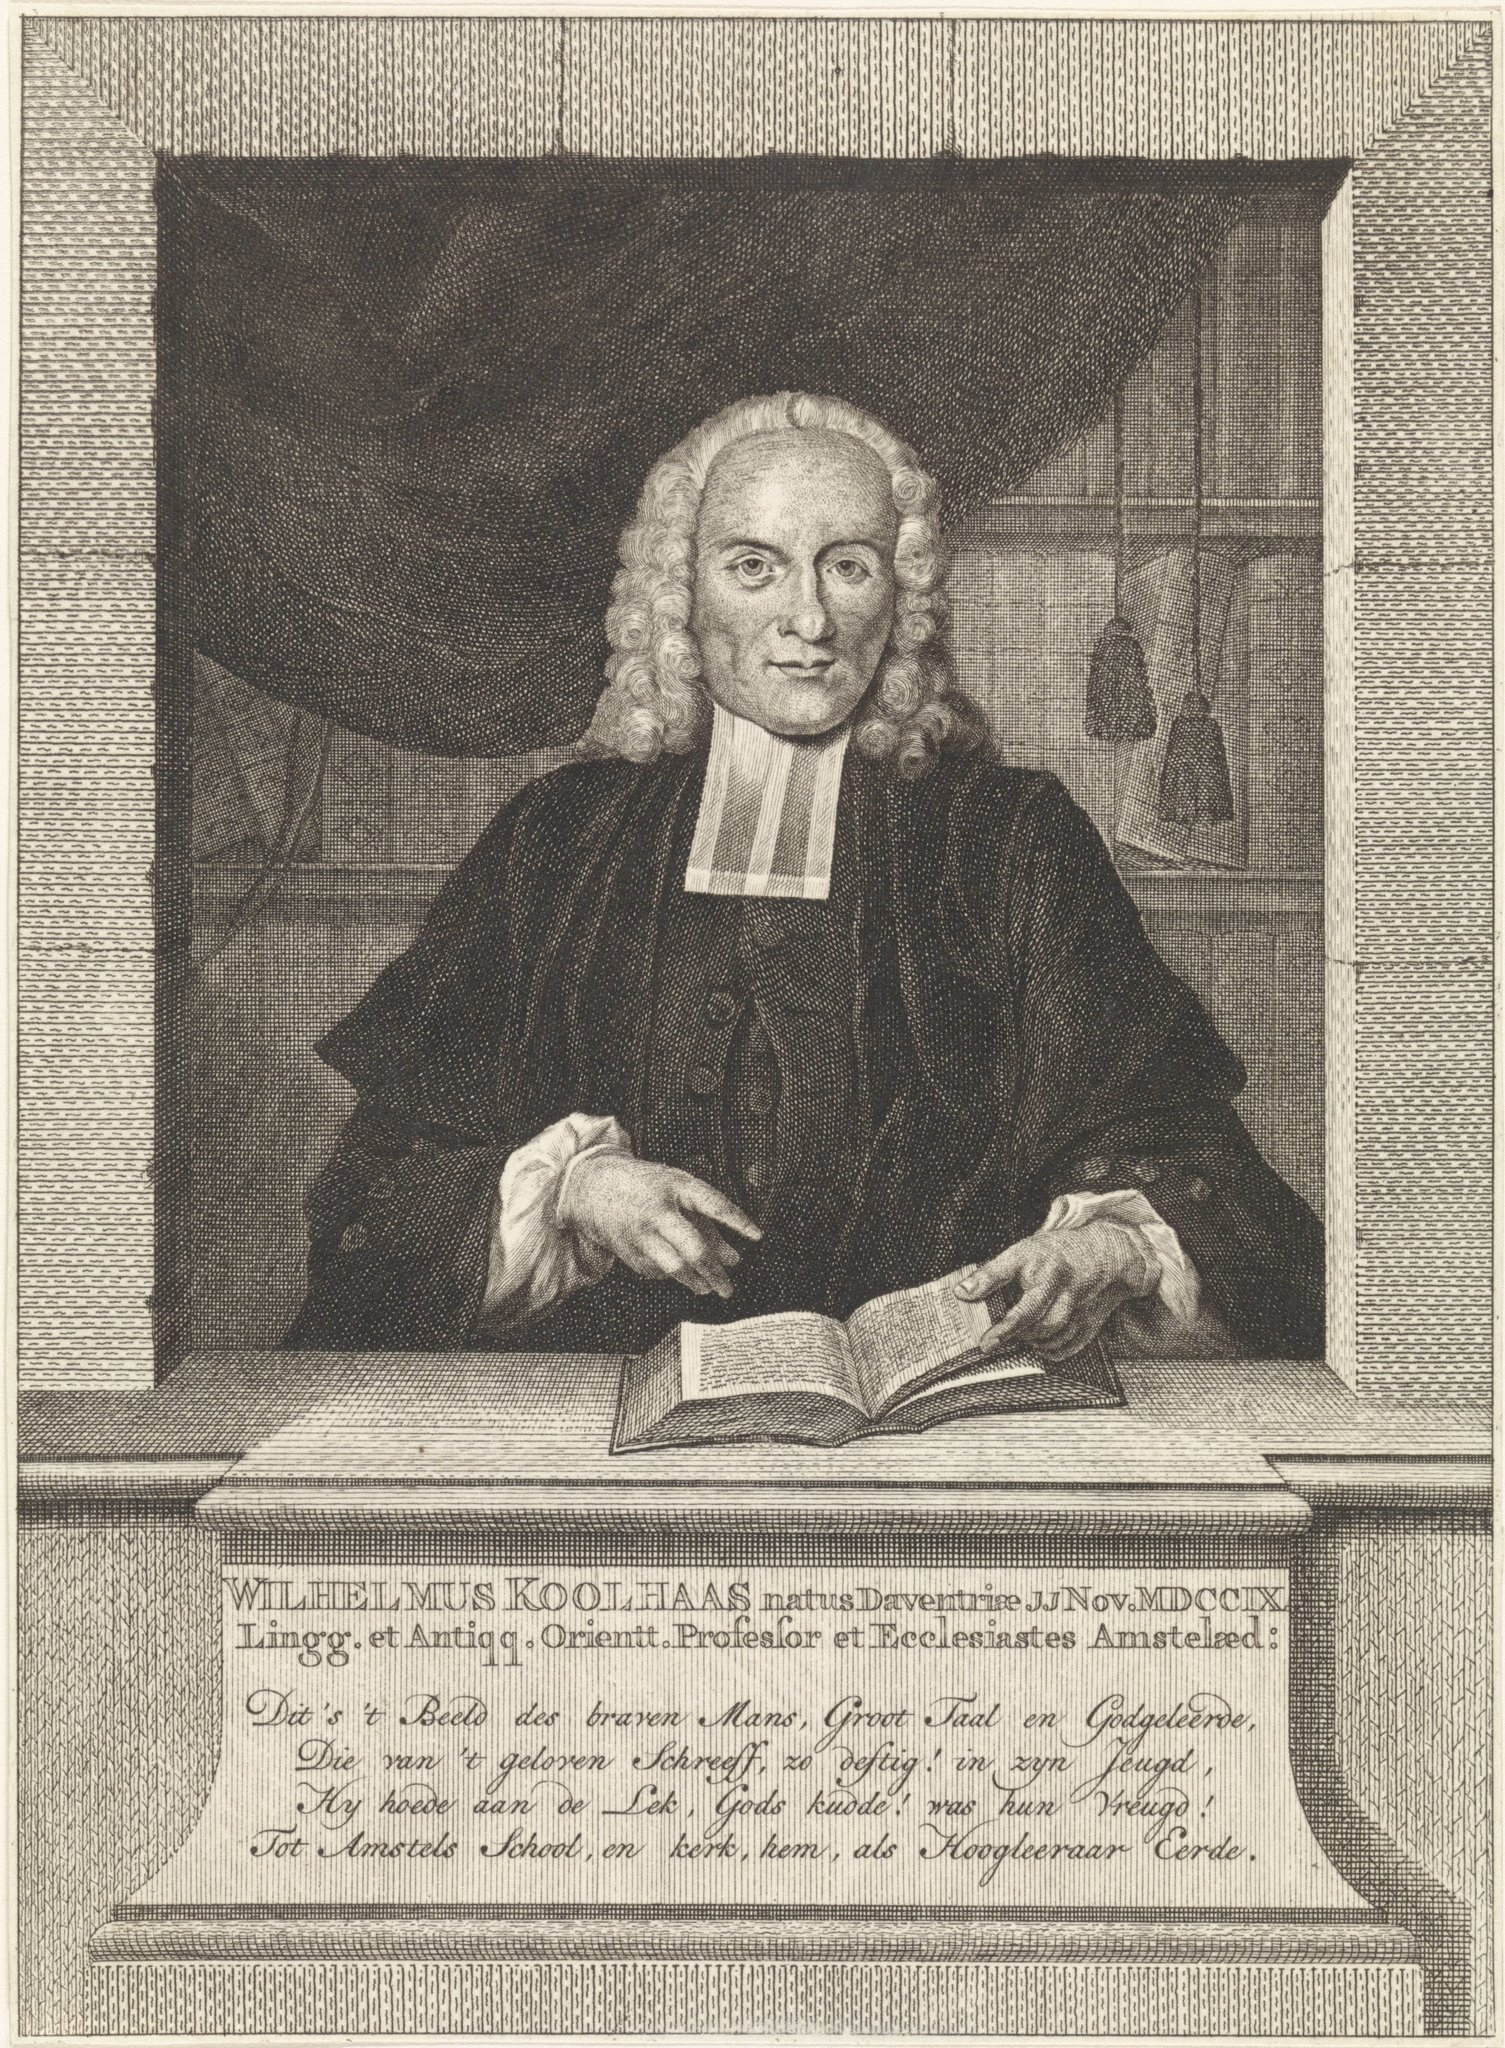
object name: print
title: Wilhelmus Koolhaas (...) et ecclesiastes Amstelaed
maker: barent de bakker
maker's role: print maker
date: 1762-1804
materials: paper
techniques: engraving, etching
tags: functionaries and dignitaries (with name) ~ episcopal protestant churches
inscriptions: collector's mark: Lugt 2228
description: Portret van predikant Willem Koolhaas met vers over zijn kwaliteiten.